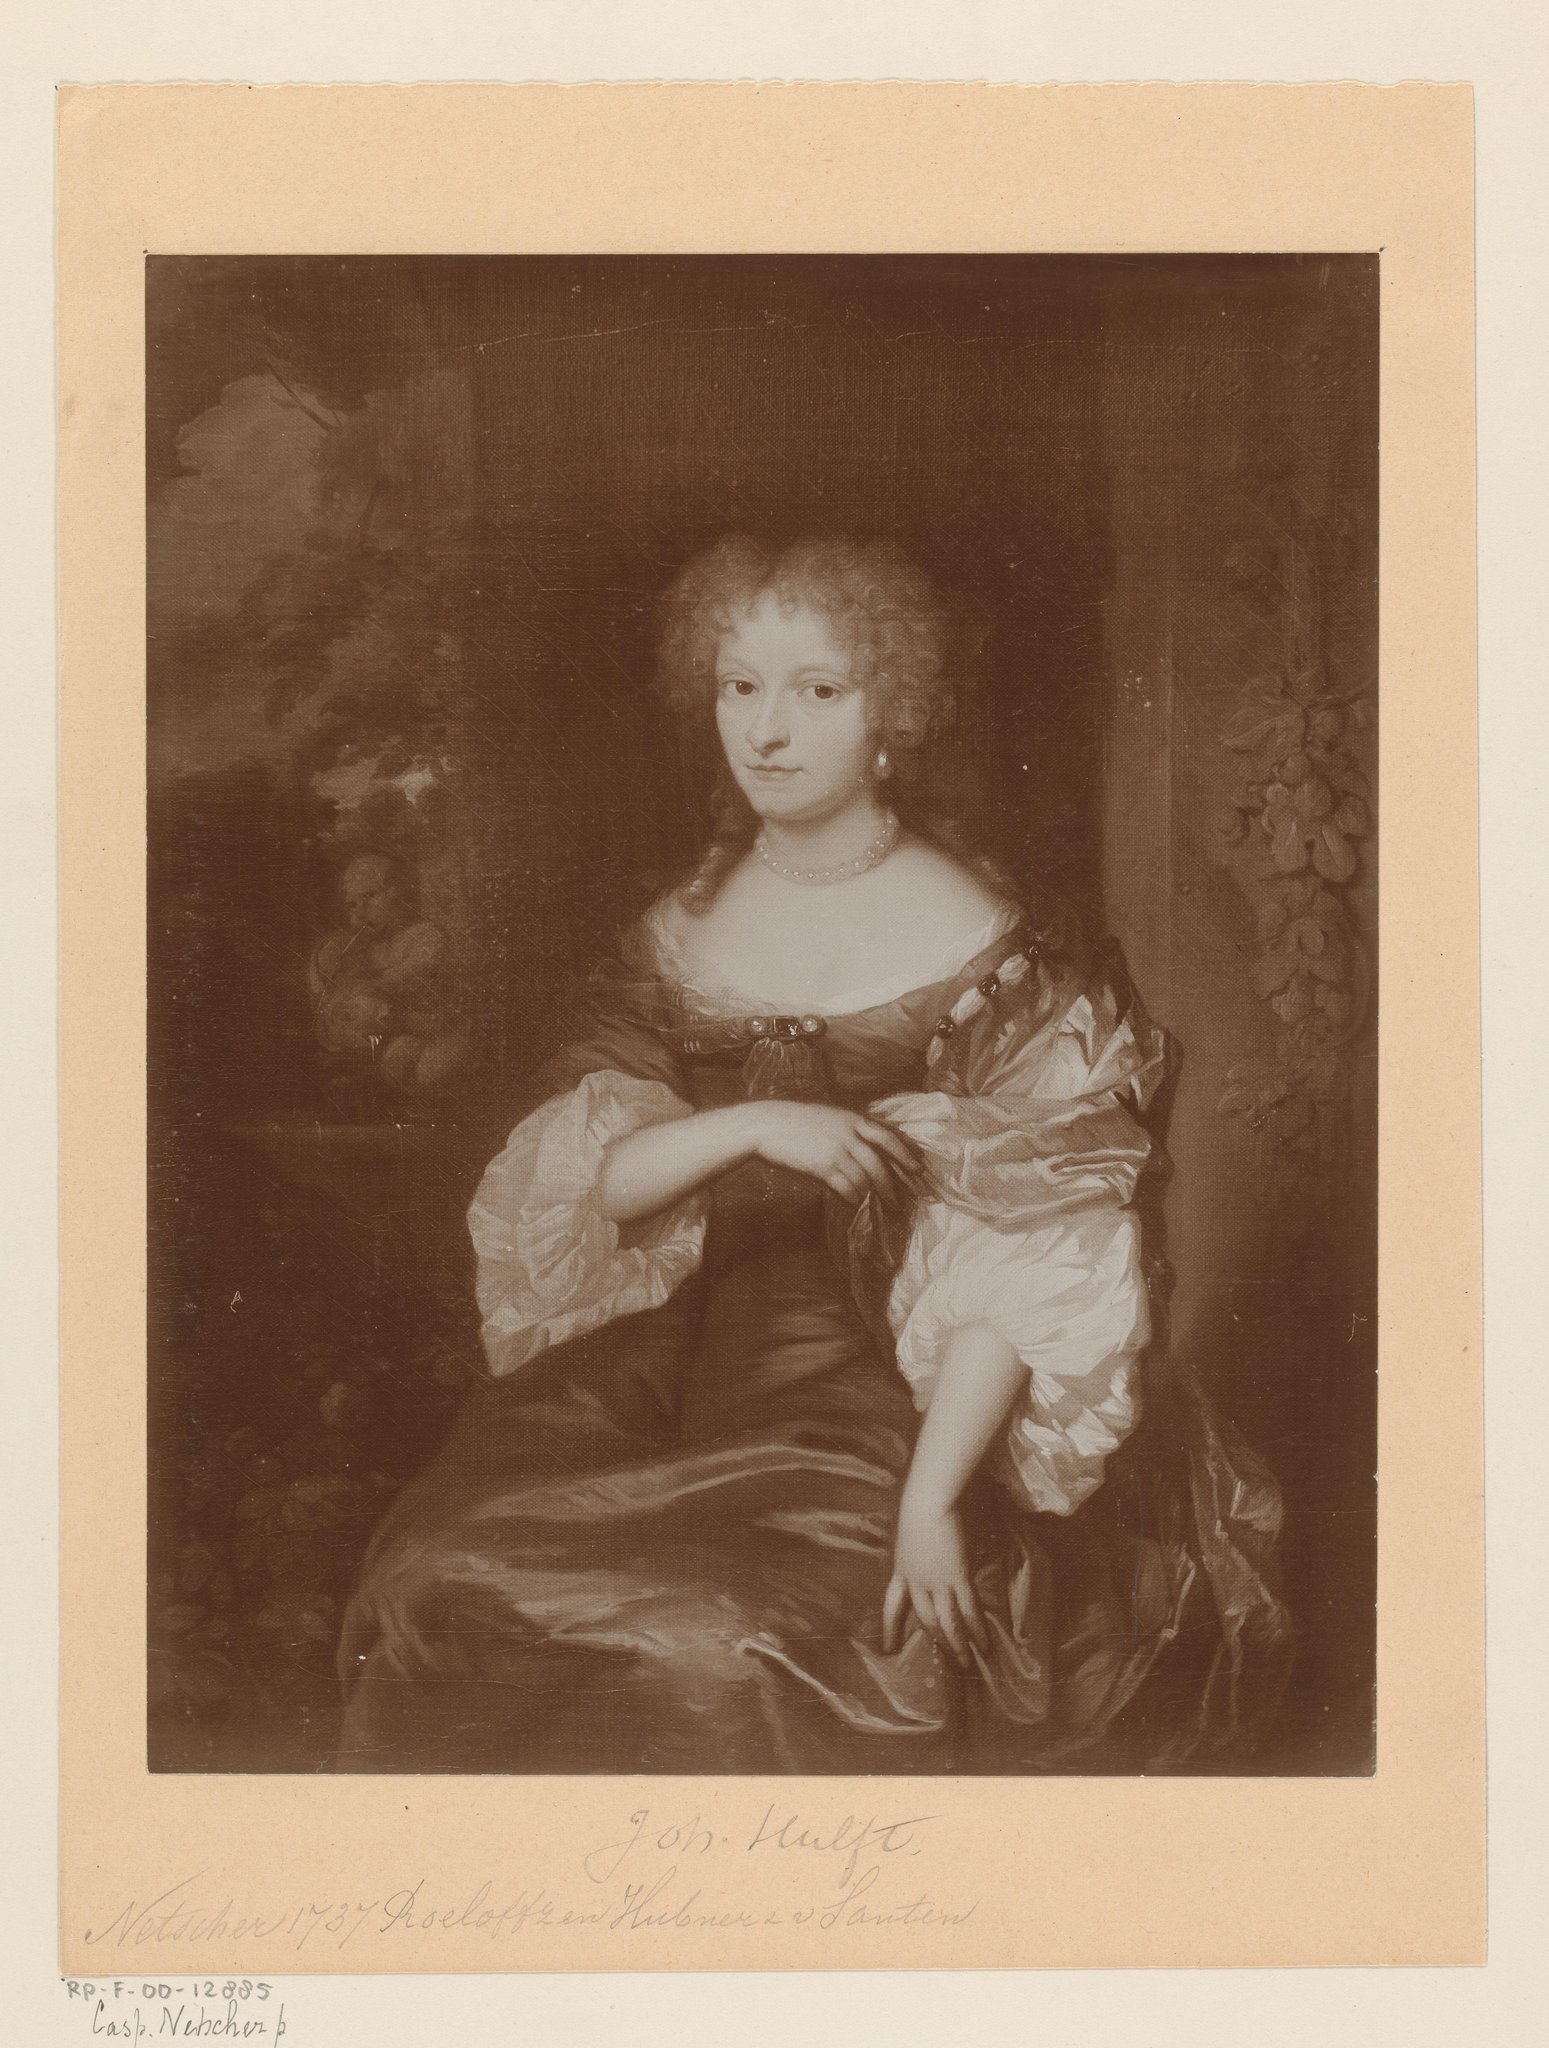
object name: reproduction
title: Fotoreproductie van een geschilderd portret van Johanna Hulft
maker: Anonymous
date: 1885-1900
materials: paper, cardboard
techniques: collodion silver print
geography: amsterdam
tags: historical persons - bb - woman, picture, painting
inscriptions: inscription: ‘Joh. Hulft,/ Netscher 1737 Roeloffzen Hubner & v Santen’